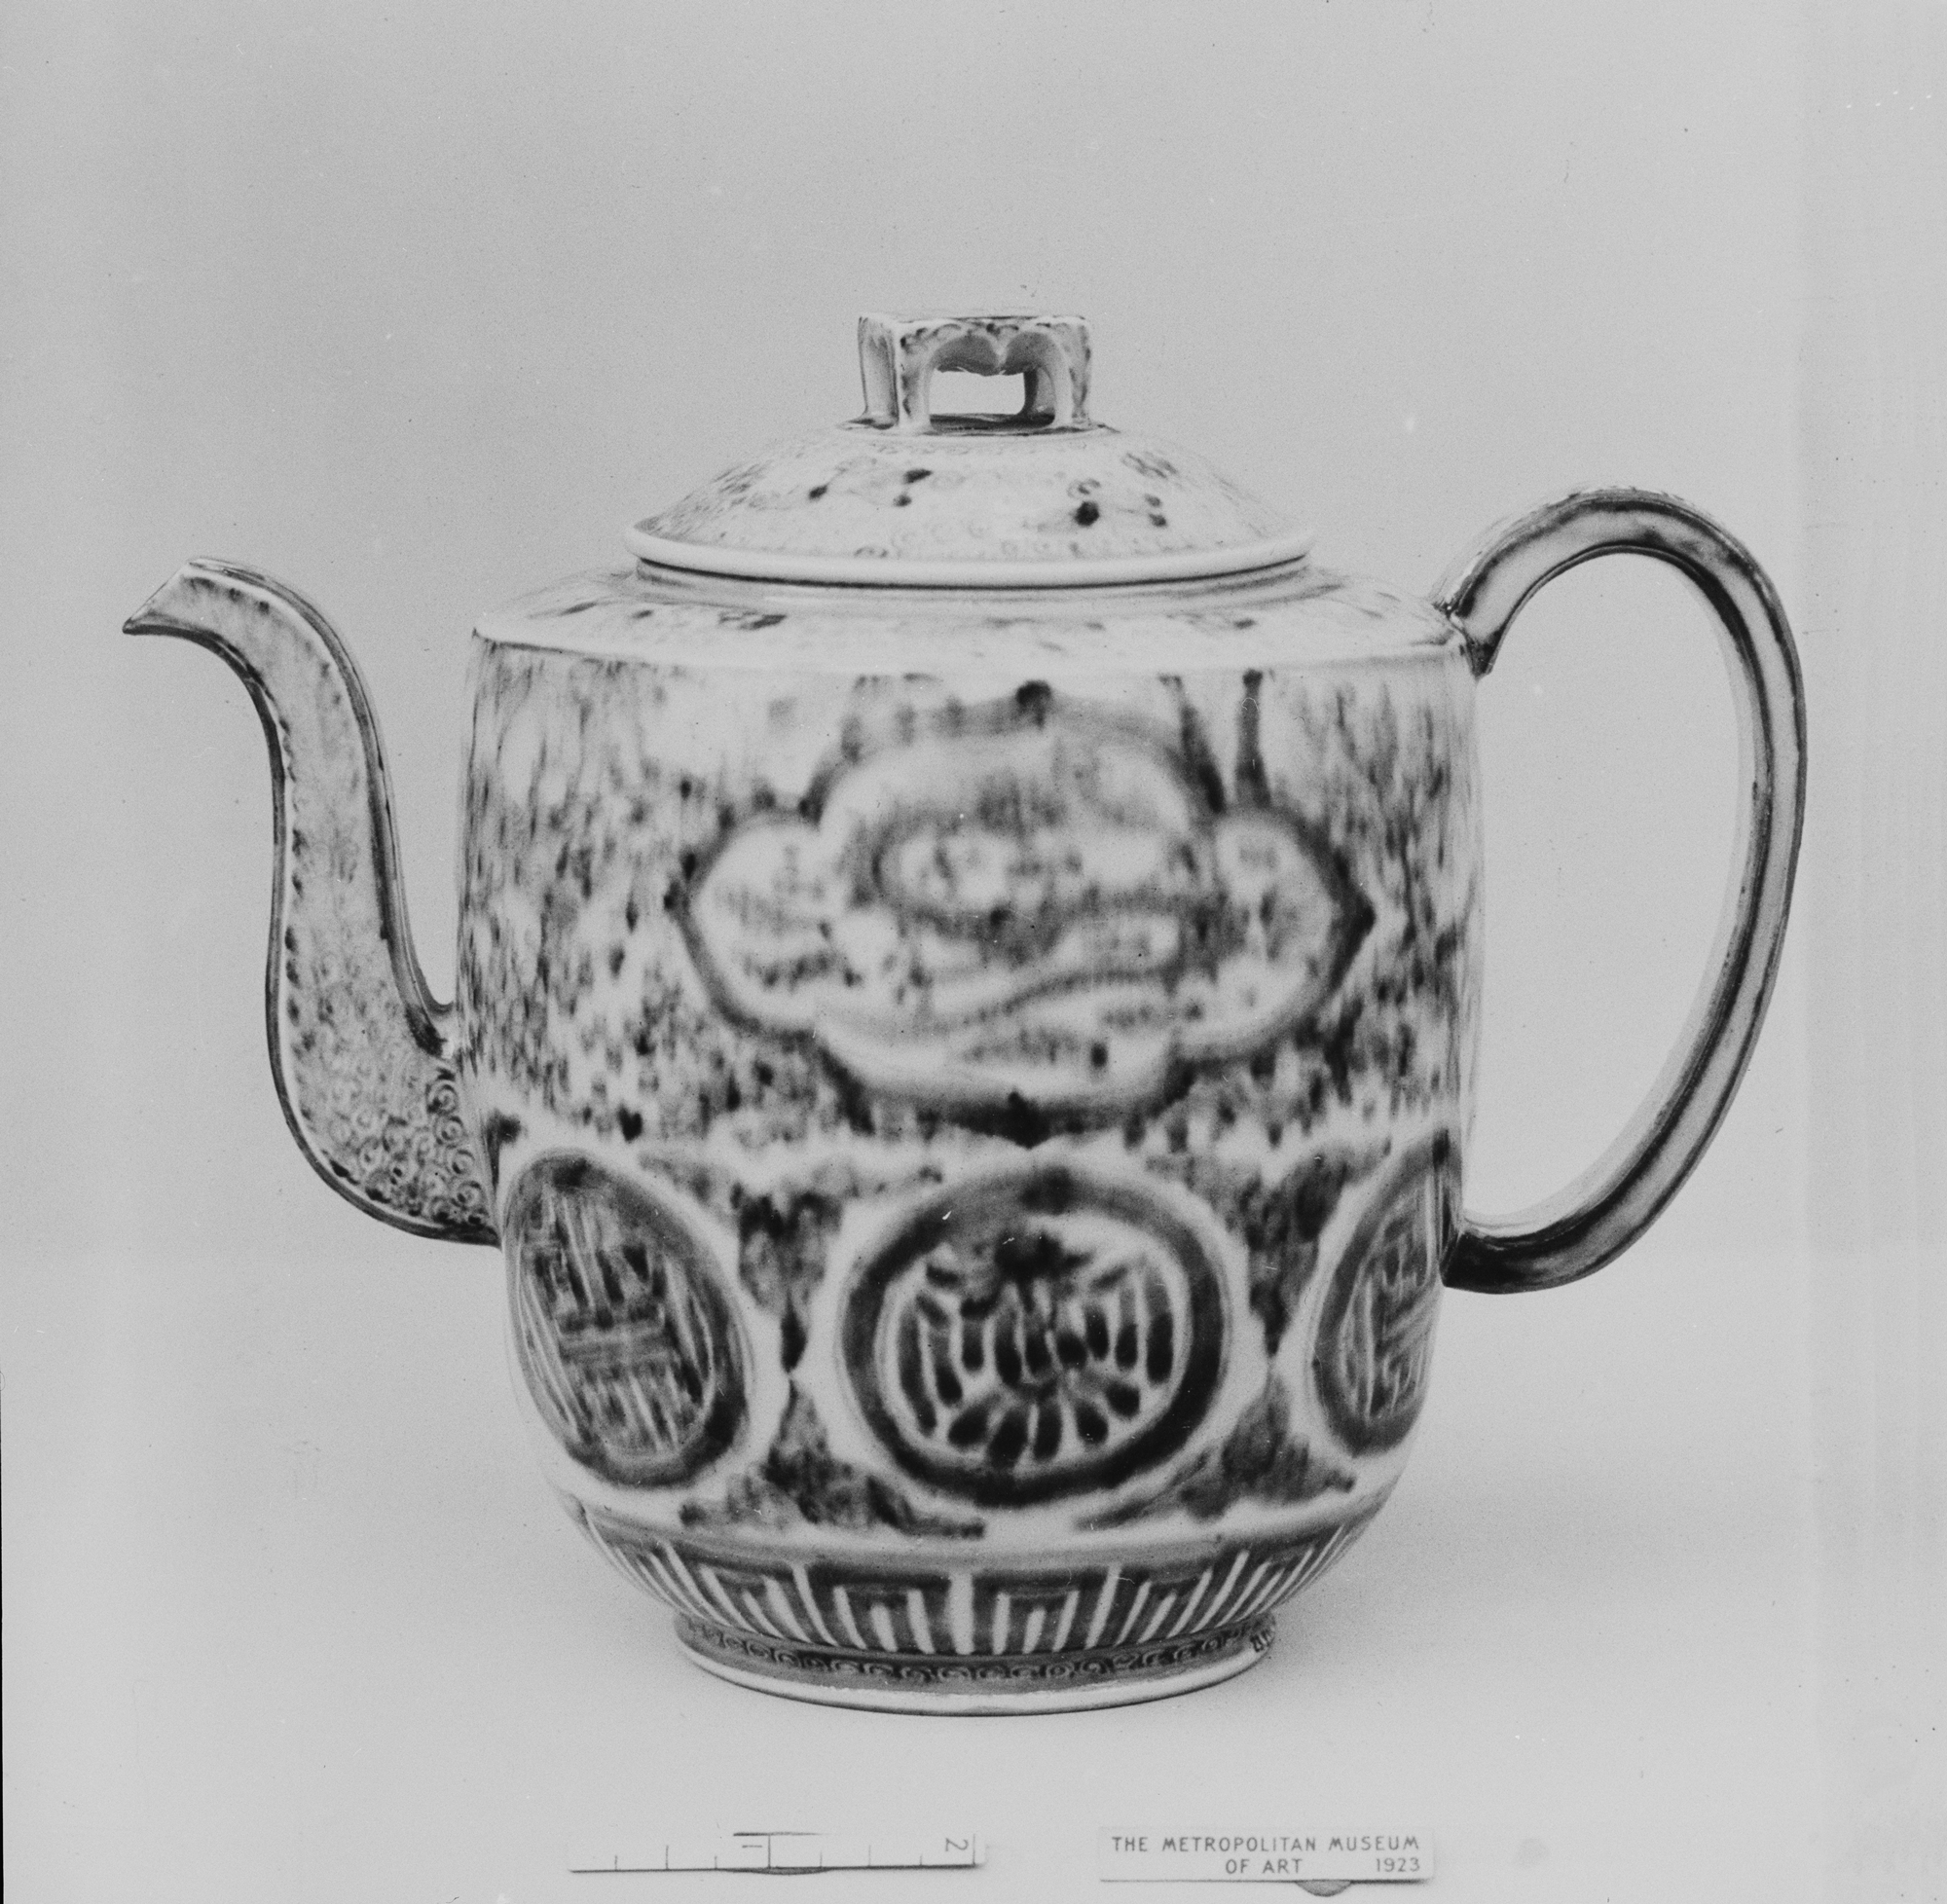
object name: water pot and cover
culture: japanese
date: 1820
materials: glaze, porcelain